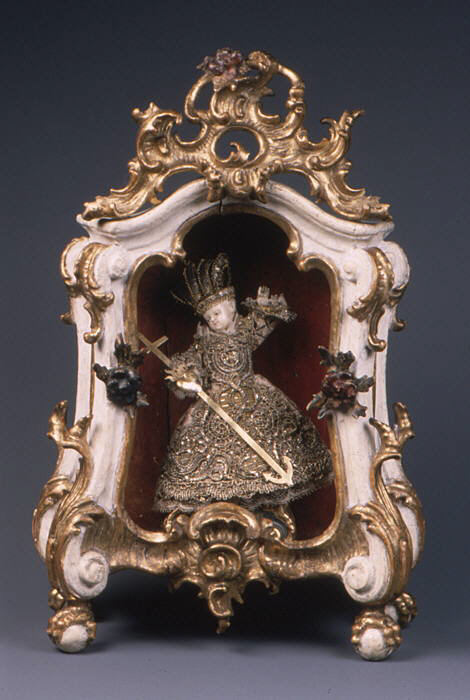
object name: reliquary vitrine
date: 1734-1766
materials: glass, wood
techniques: gilding, polychrome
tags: cross,jesus,reliquaries